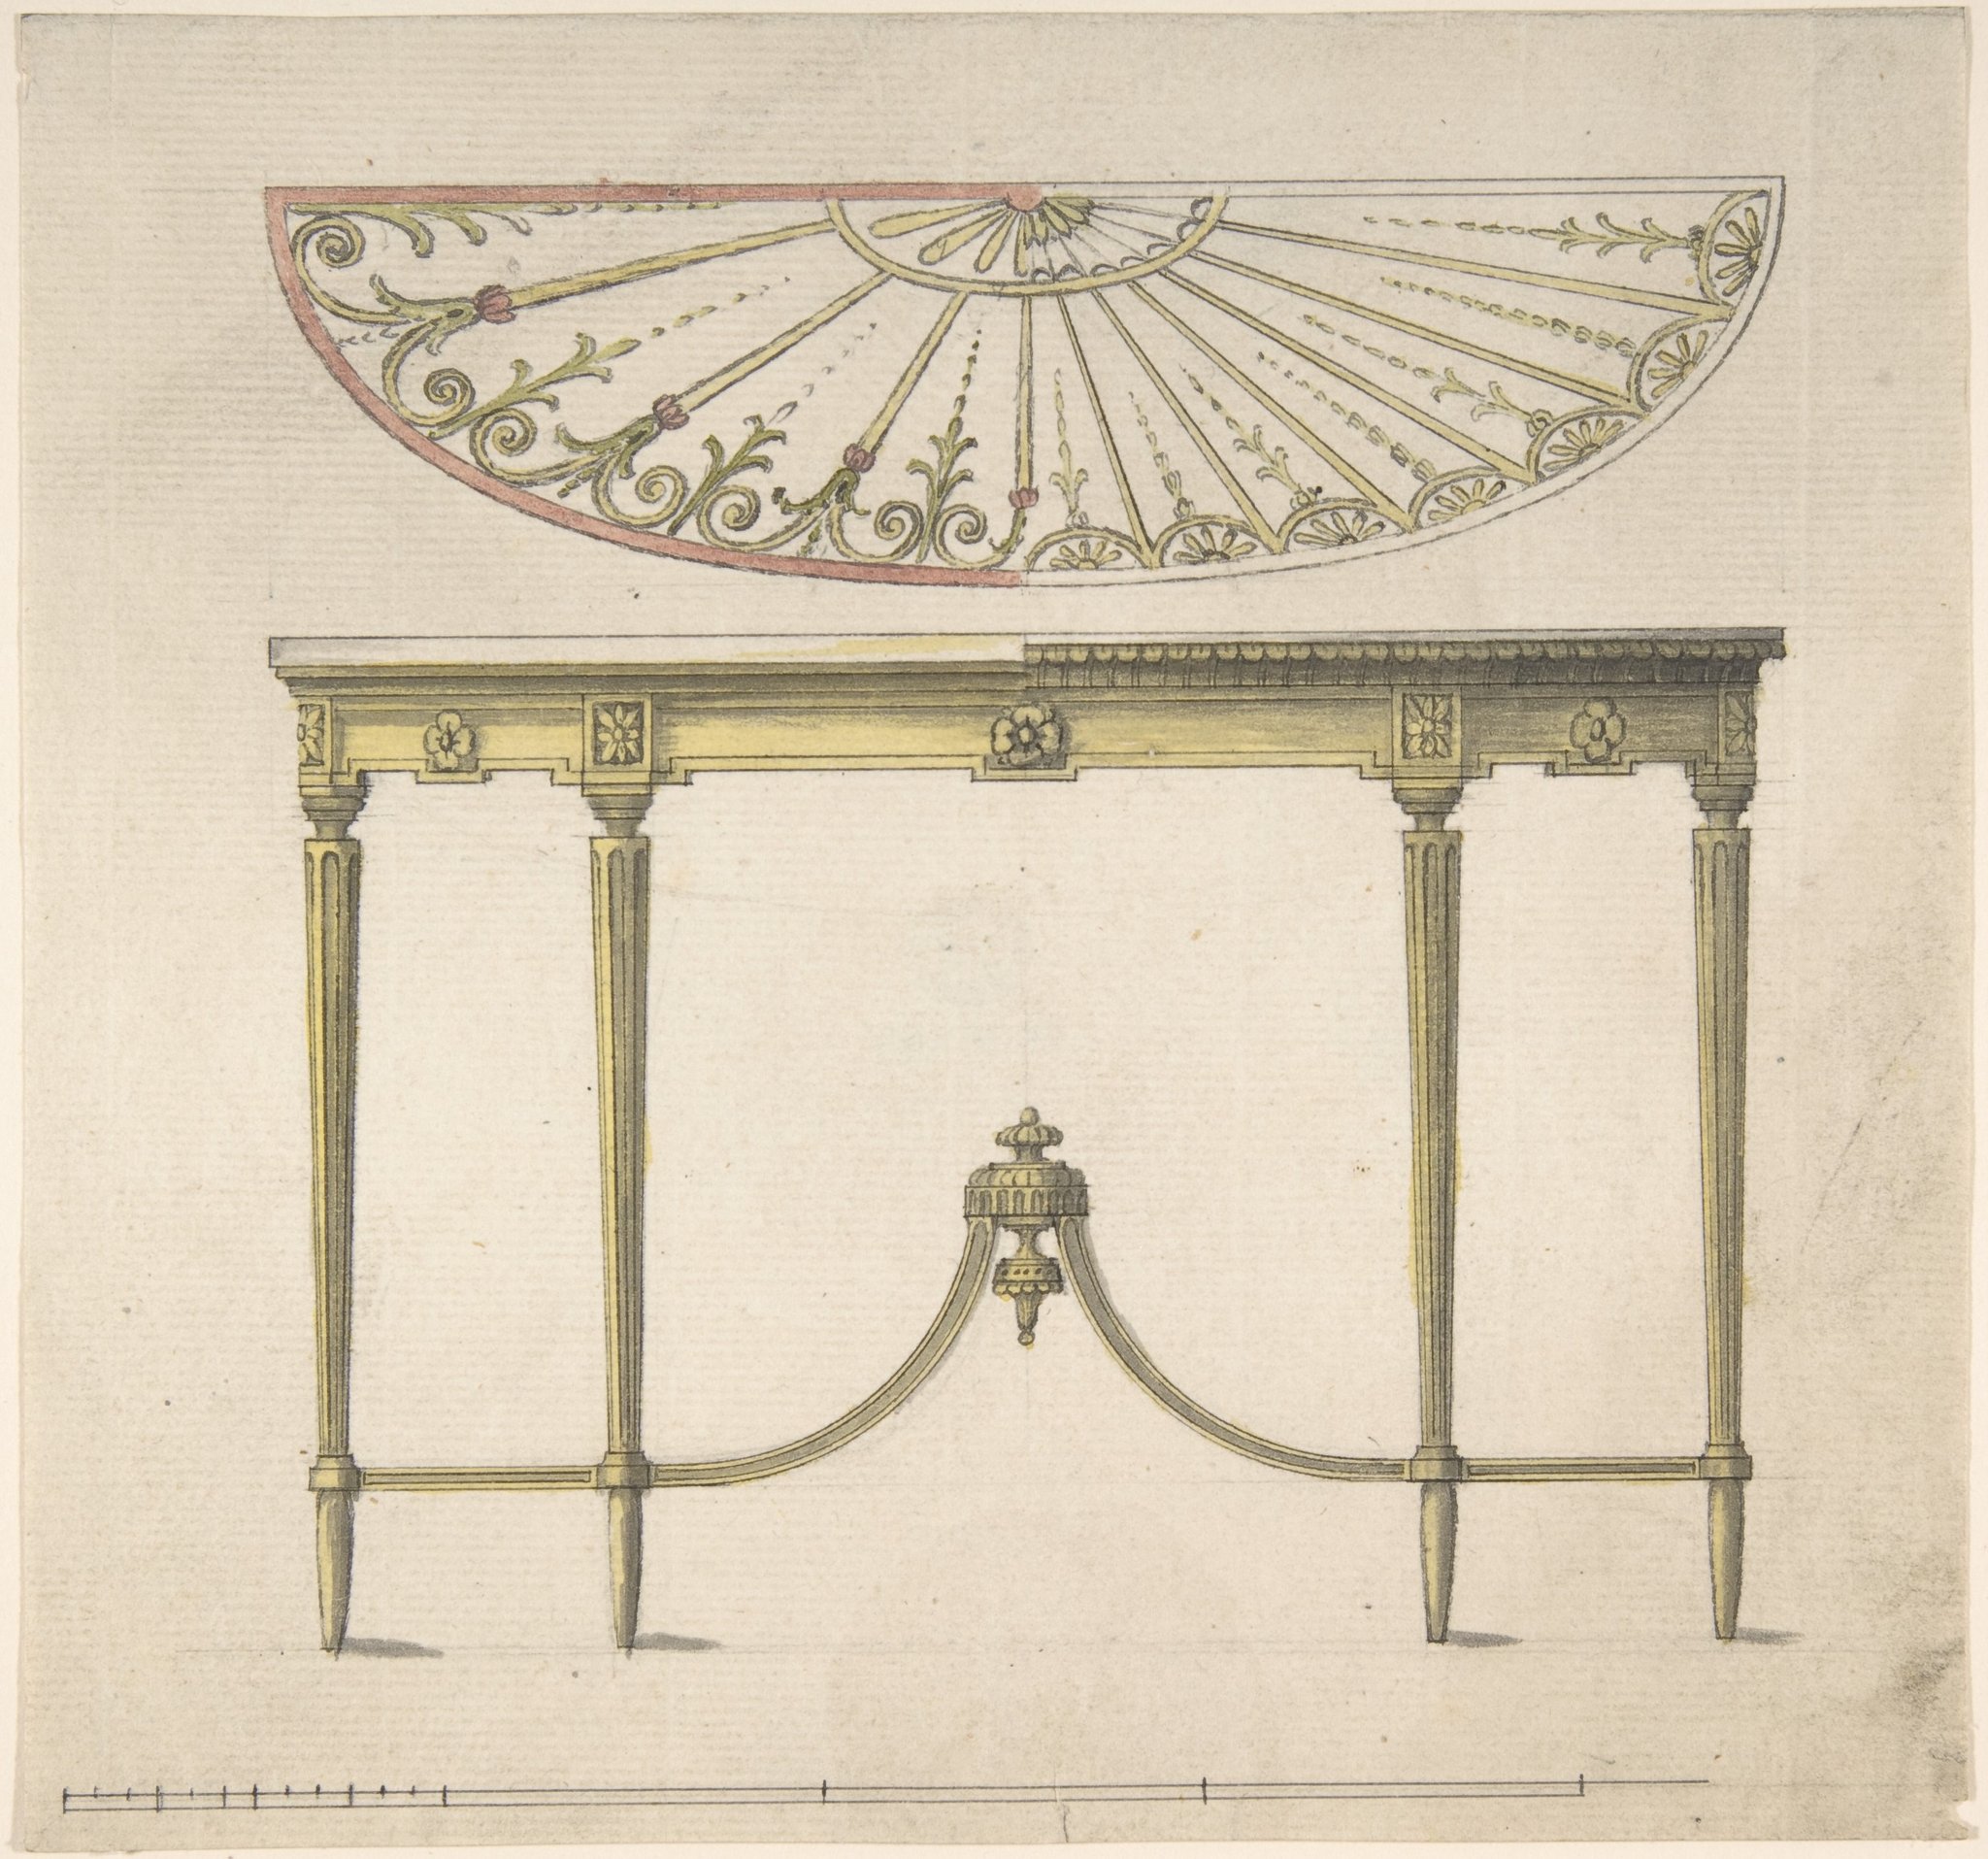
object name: drawing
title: Design for a Console Table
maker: robert adam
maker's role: artist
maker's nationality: british, scottish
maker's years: 1728-1792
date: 1751-1800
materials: graphite, ink, watercolor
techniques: pen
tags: tables